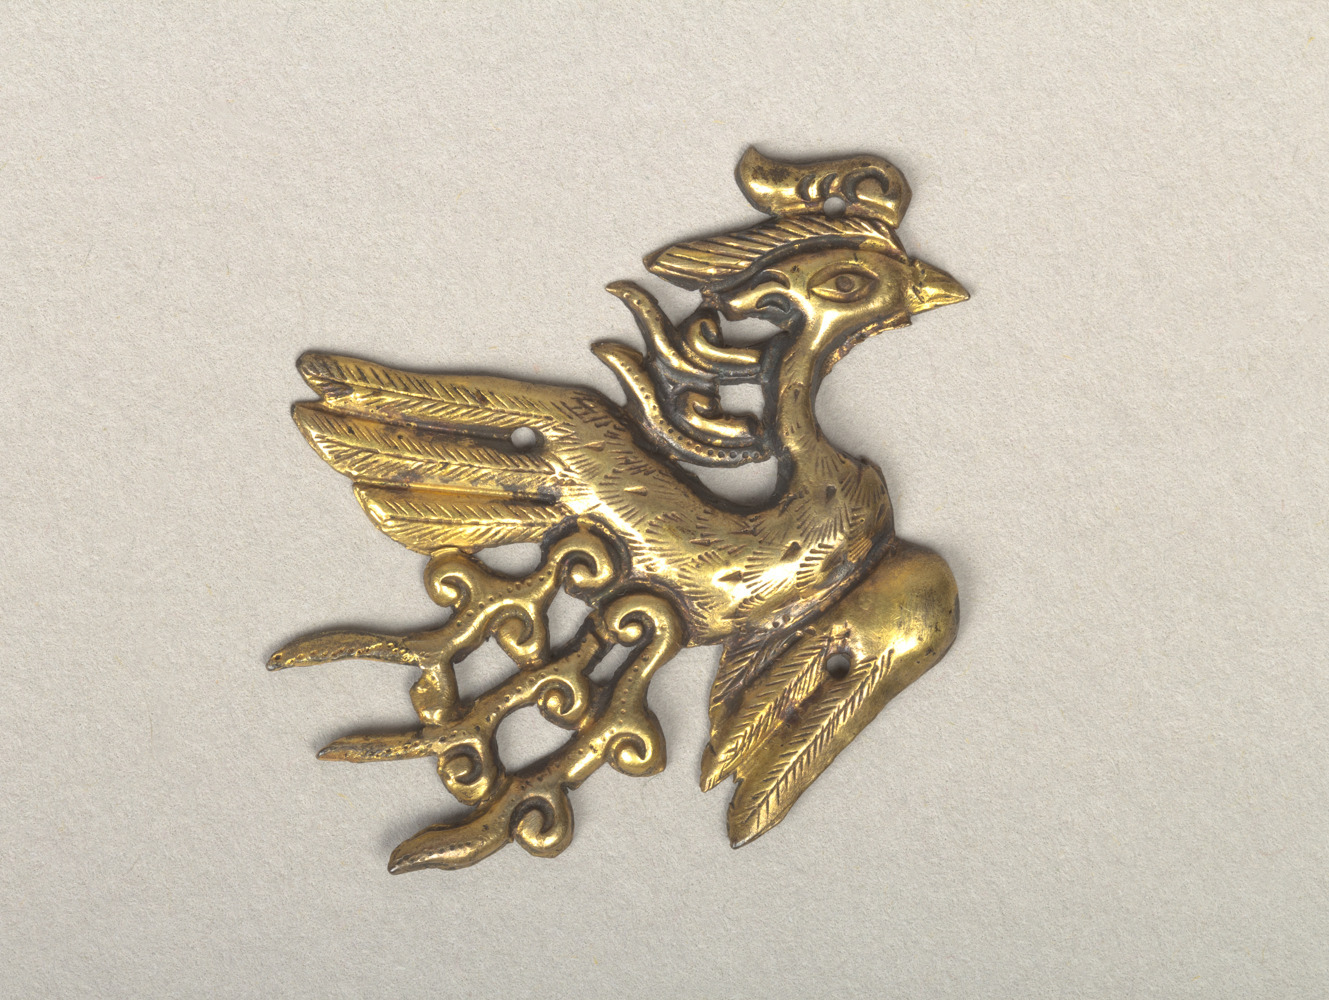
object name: ornament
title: Ornament in the shape of a phoenix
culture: korean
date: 918-1392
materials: gold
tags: phoenix